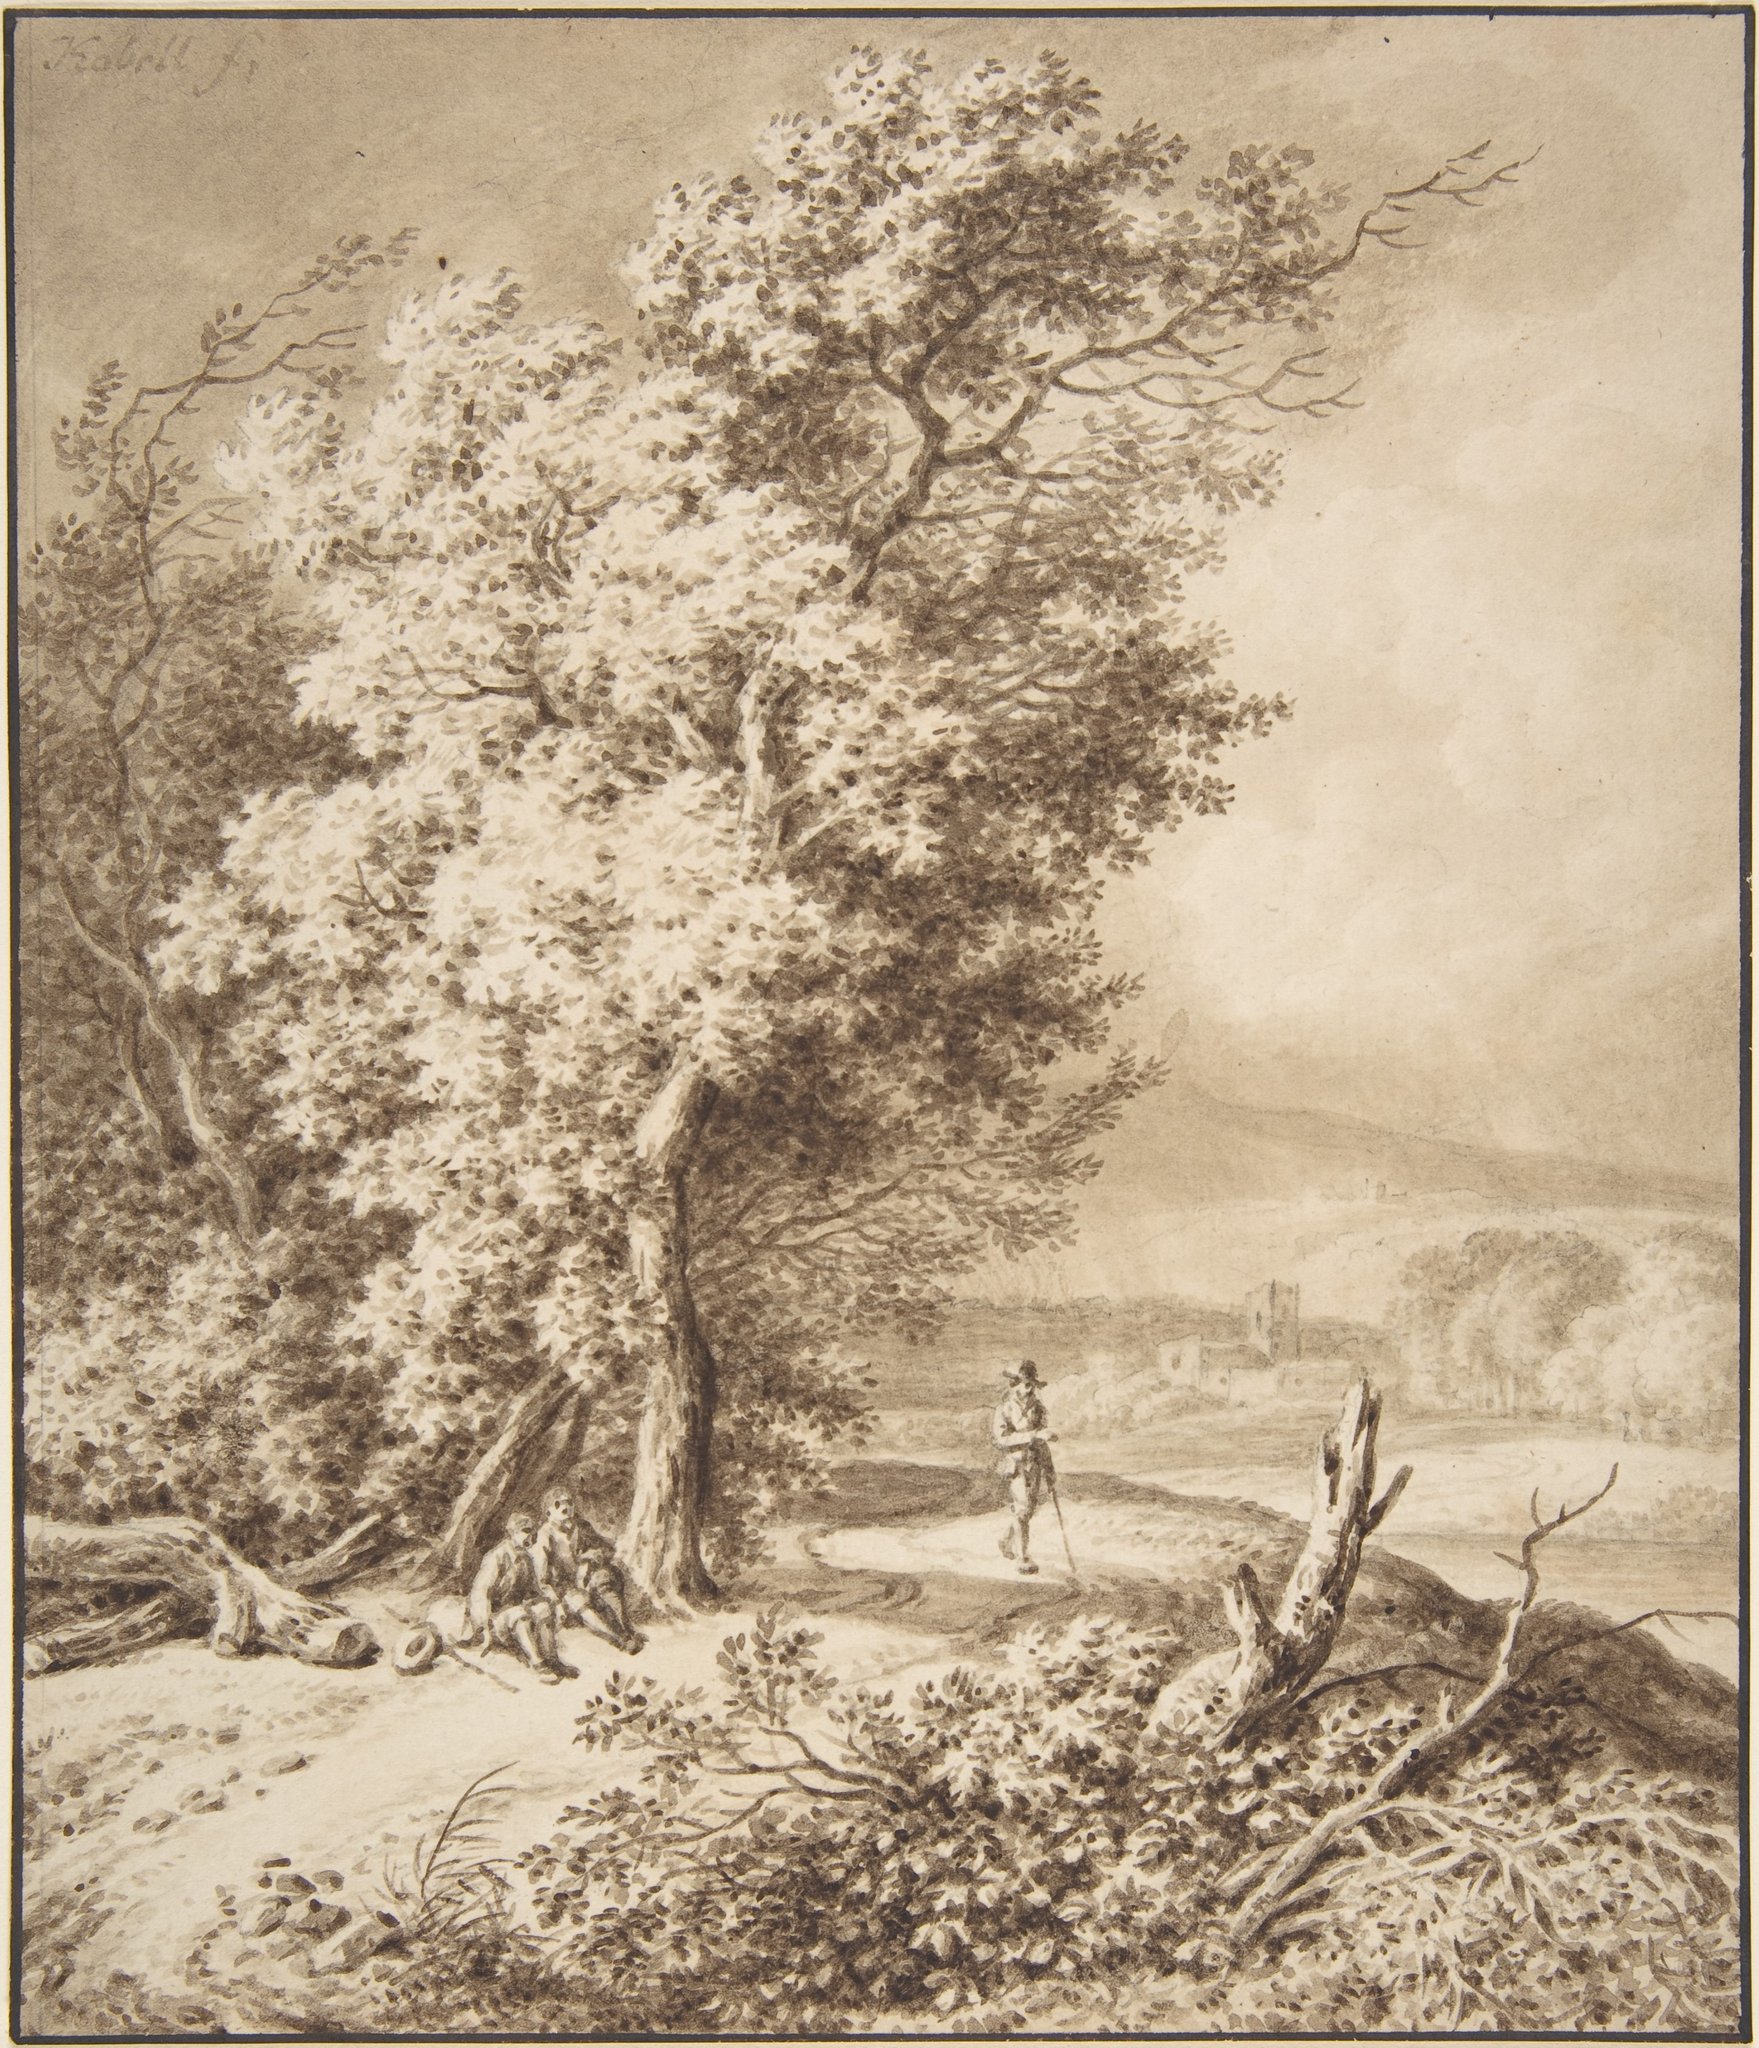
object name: drawing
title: Landscape with Wayfarers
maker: ferdinand kobell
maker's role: artist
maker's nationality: german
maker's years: 1740-1799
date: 1740-1799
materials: chalk, graphite, ink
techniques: brush, pen, wash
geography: germany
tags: men,landscapes,trees